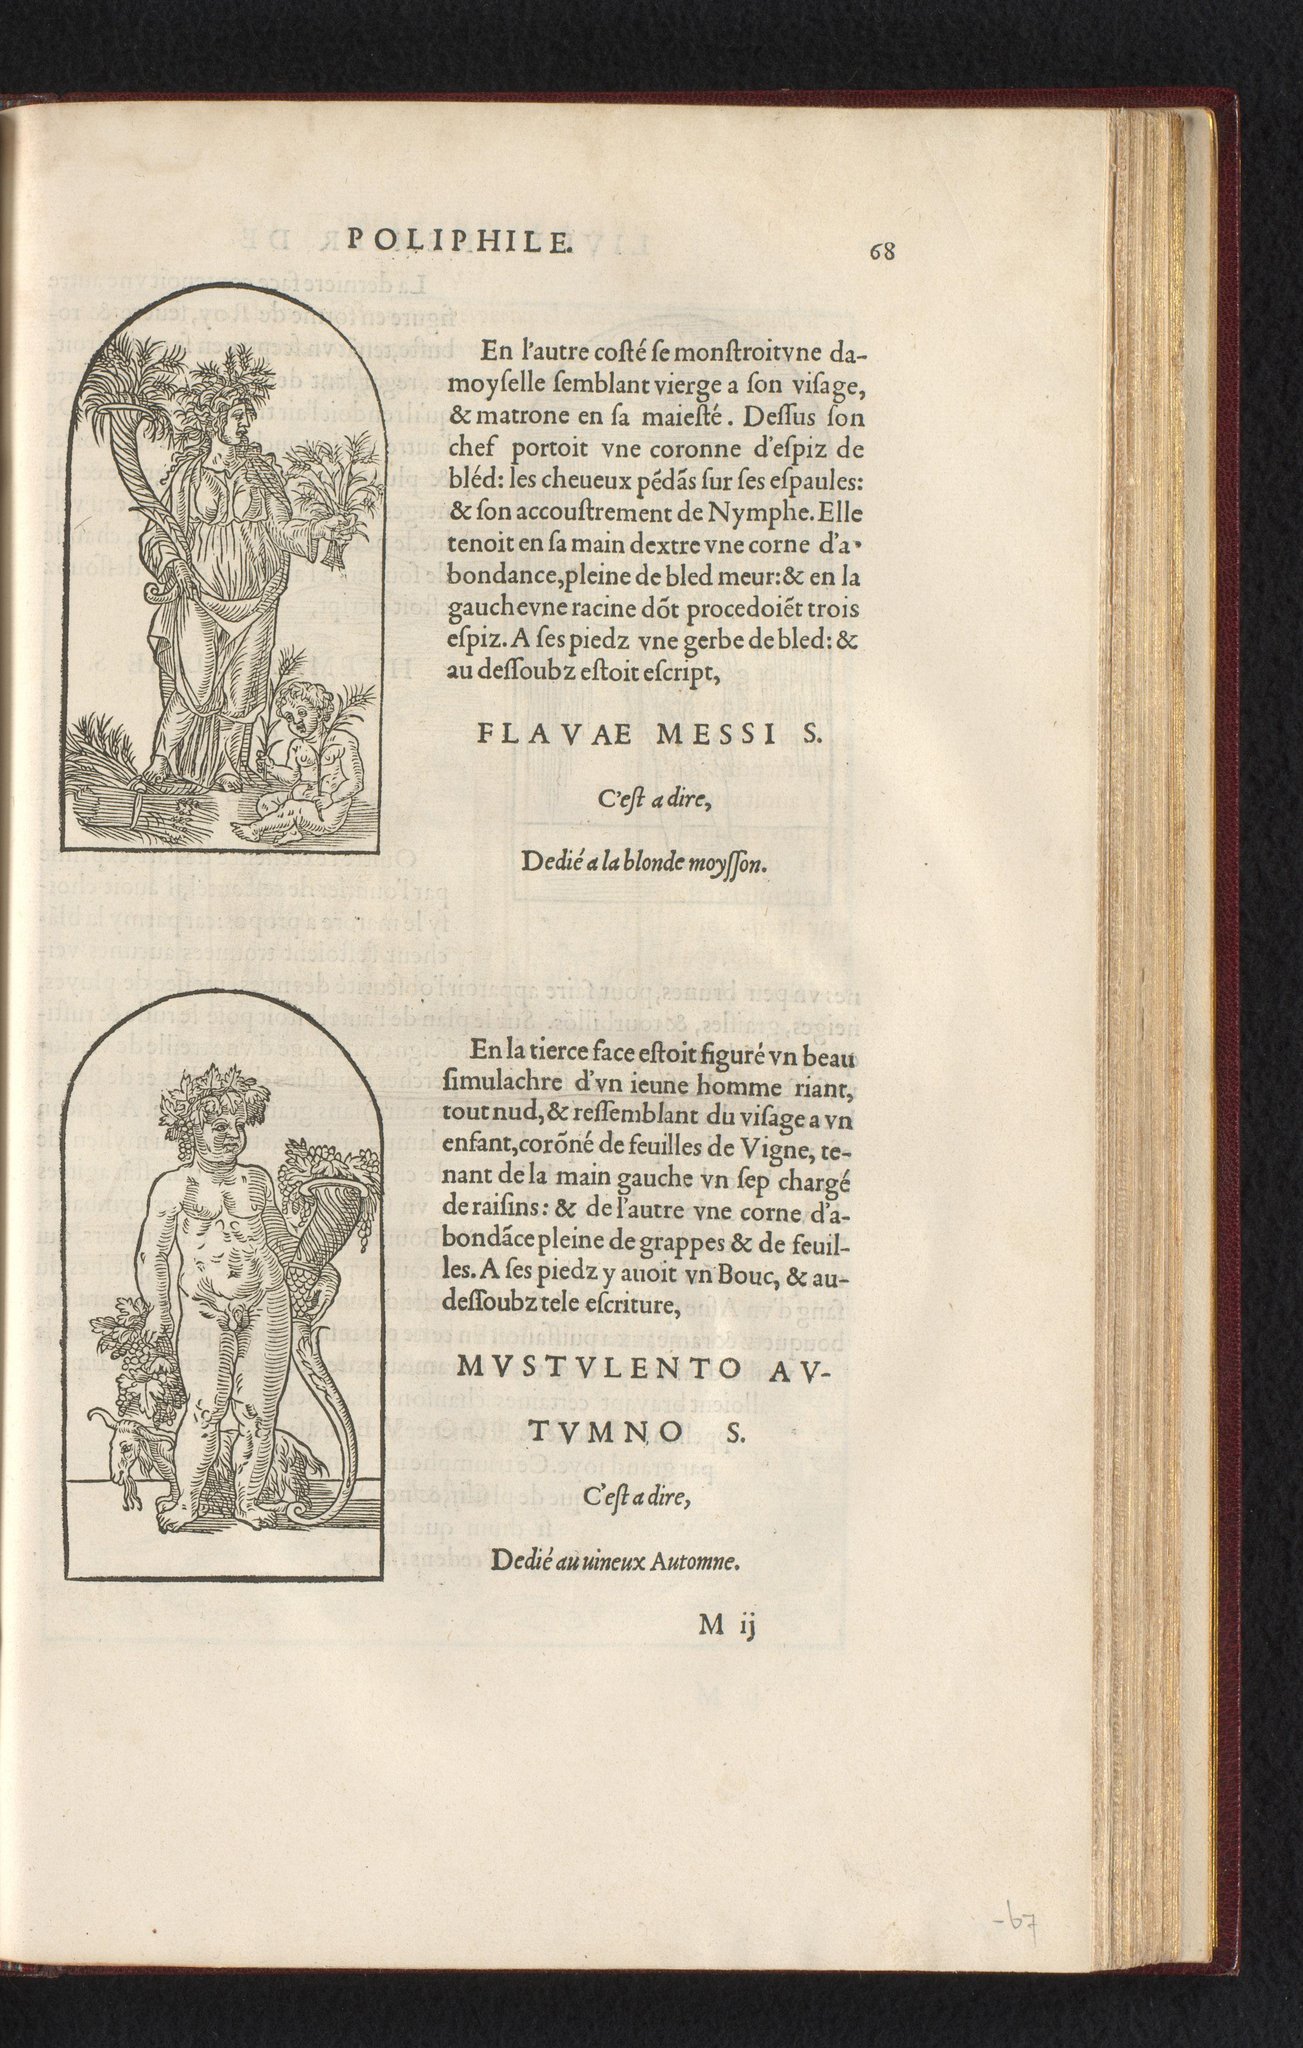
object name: page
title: Vrouw met cornucopia en graan en Bacchus met cornucopia en geit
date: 1546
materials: paper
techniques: letterpress printing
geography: paris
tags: harvest, 'cornucopia', horn of plenty, (story of) bacchus (dionysus), liber, (scenes from) specific works of literature: colonna, hypnerotomachia poliphili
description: Prent uit: Colonna, Francesco. Hypnerotomachie ou discours du songe de Poliphile, deduisant comme amour le combat a l'occasion de Polia. Parijs: Jacques Kerver, 1546, recto fol. 68.